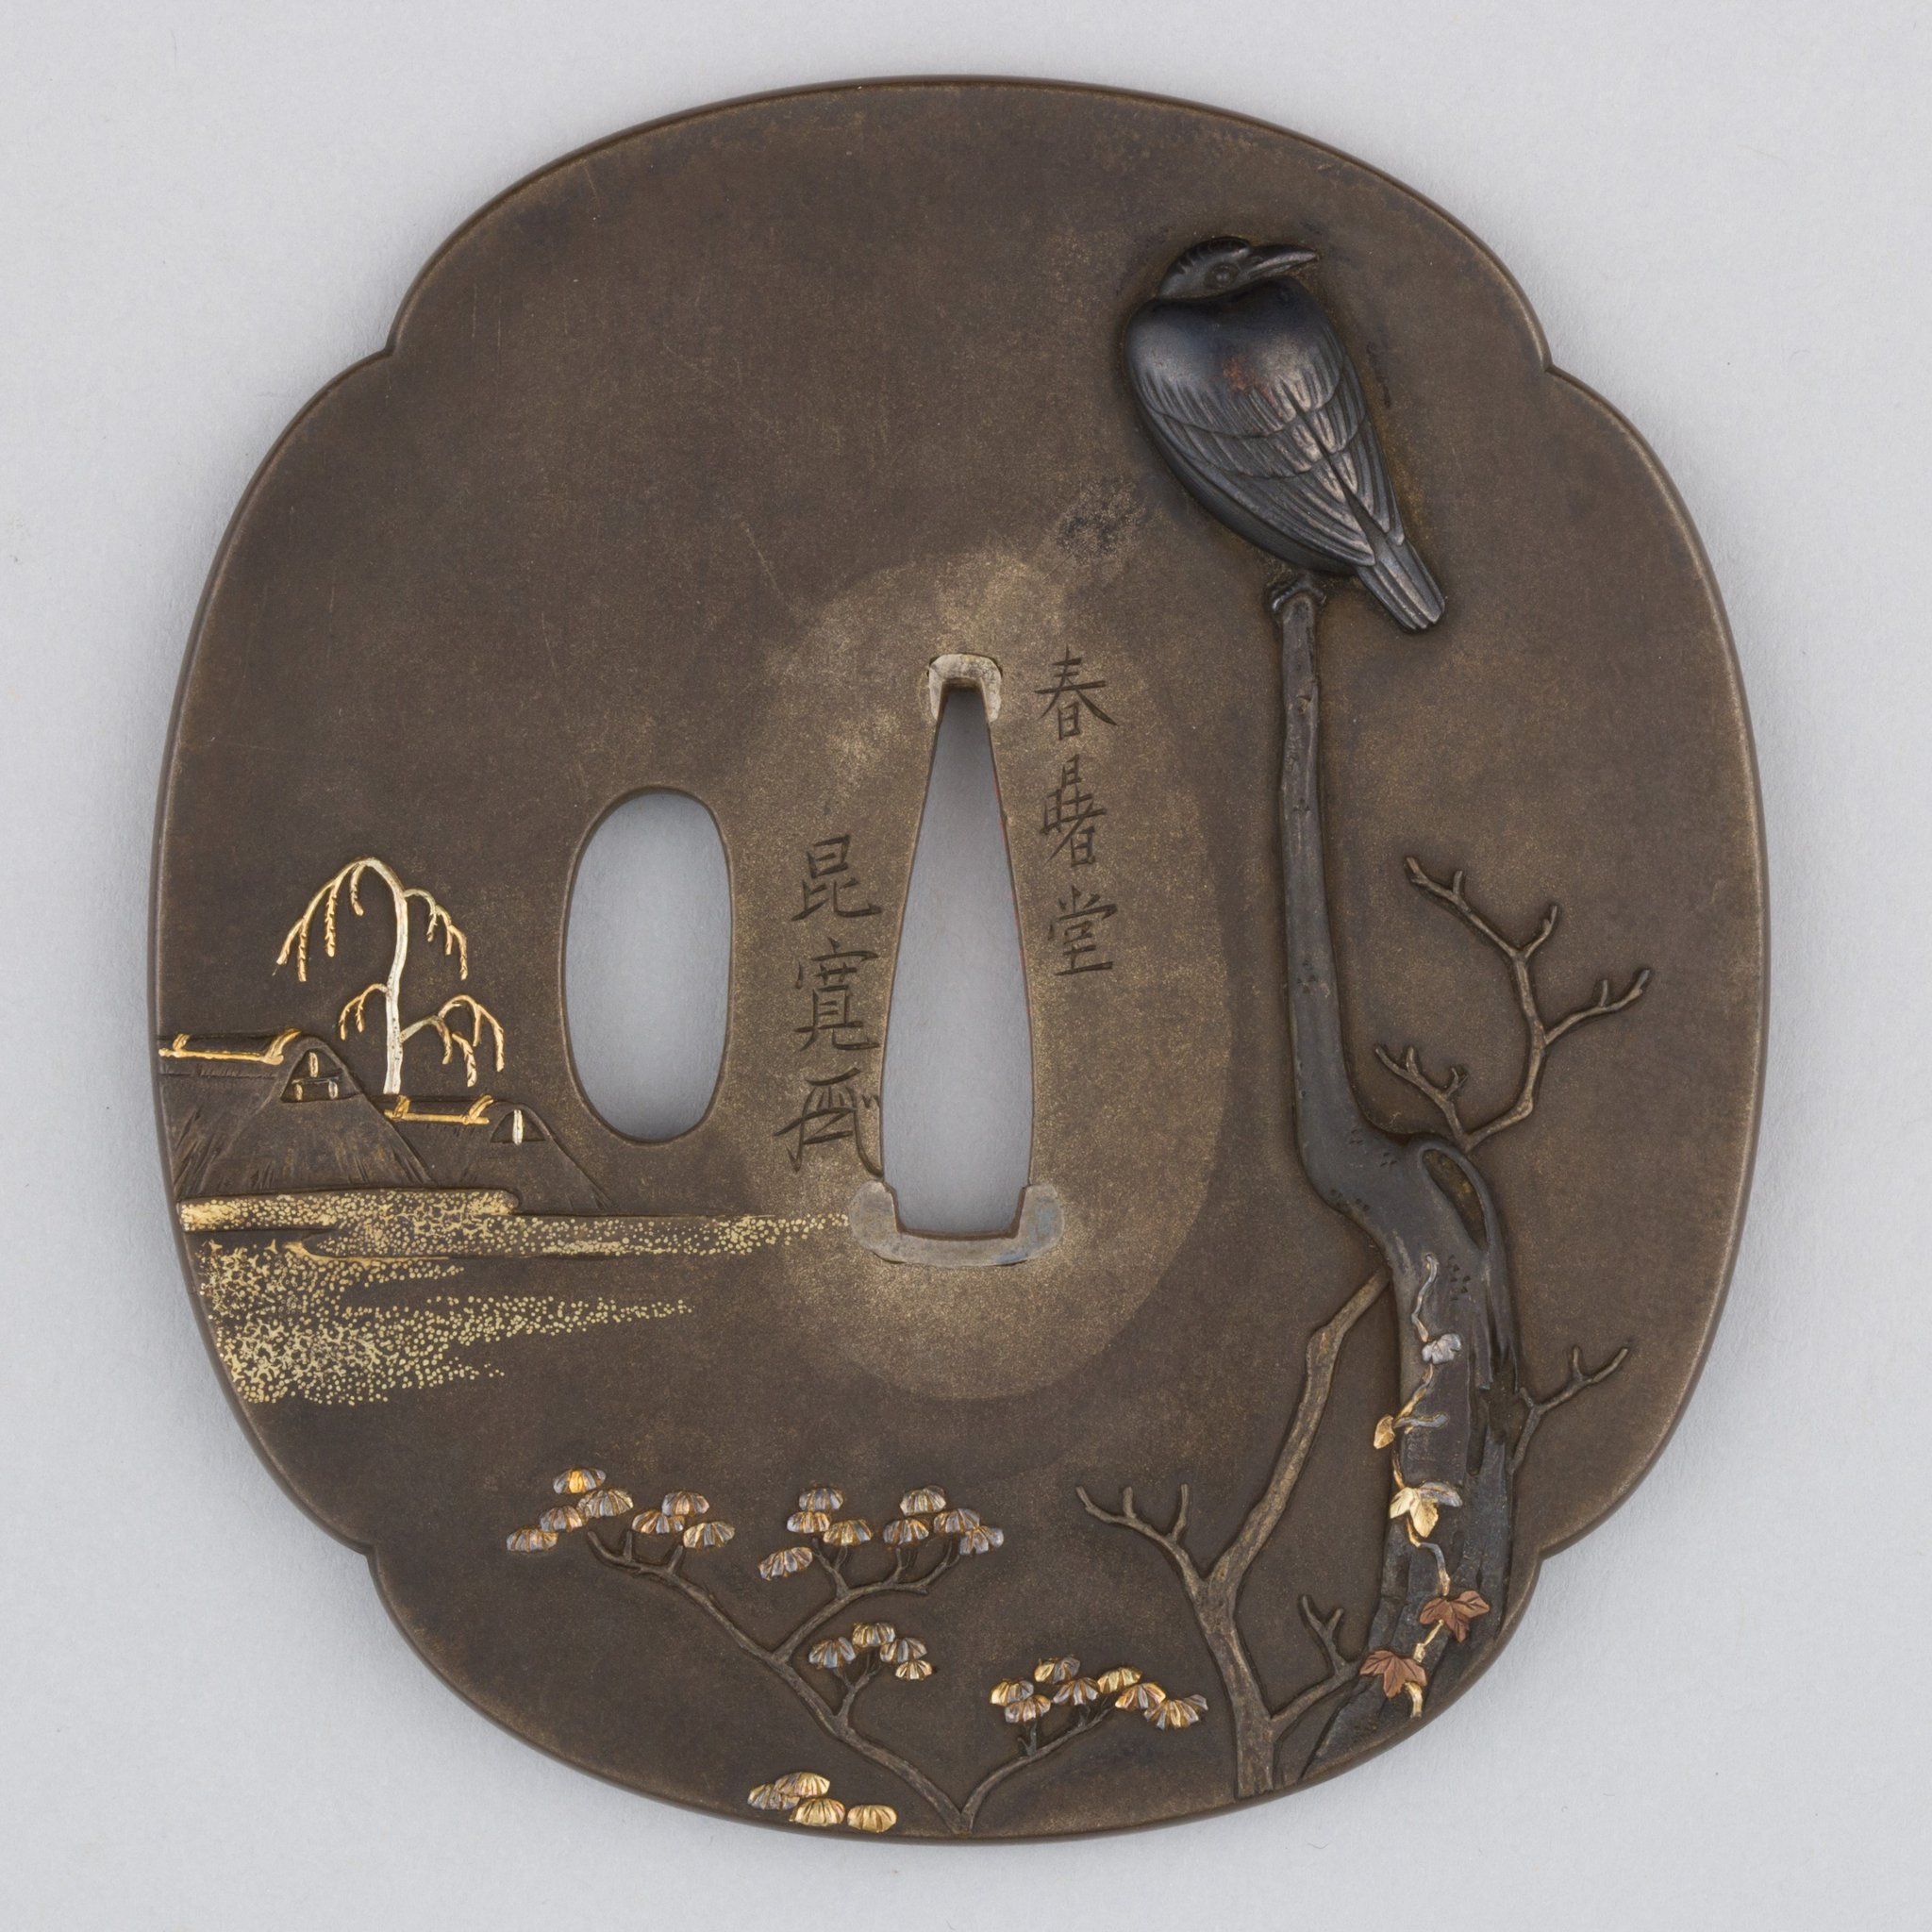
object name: sword guard tsuba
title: Sword Guard (Tsuba)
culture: japanese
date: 1615-1868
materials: copper, gold alloy, silver alloy, gold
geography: japan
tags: birds,trees